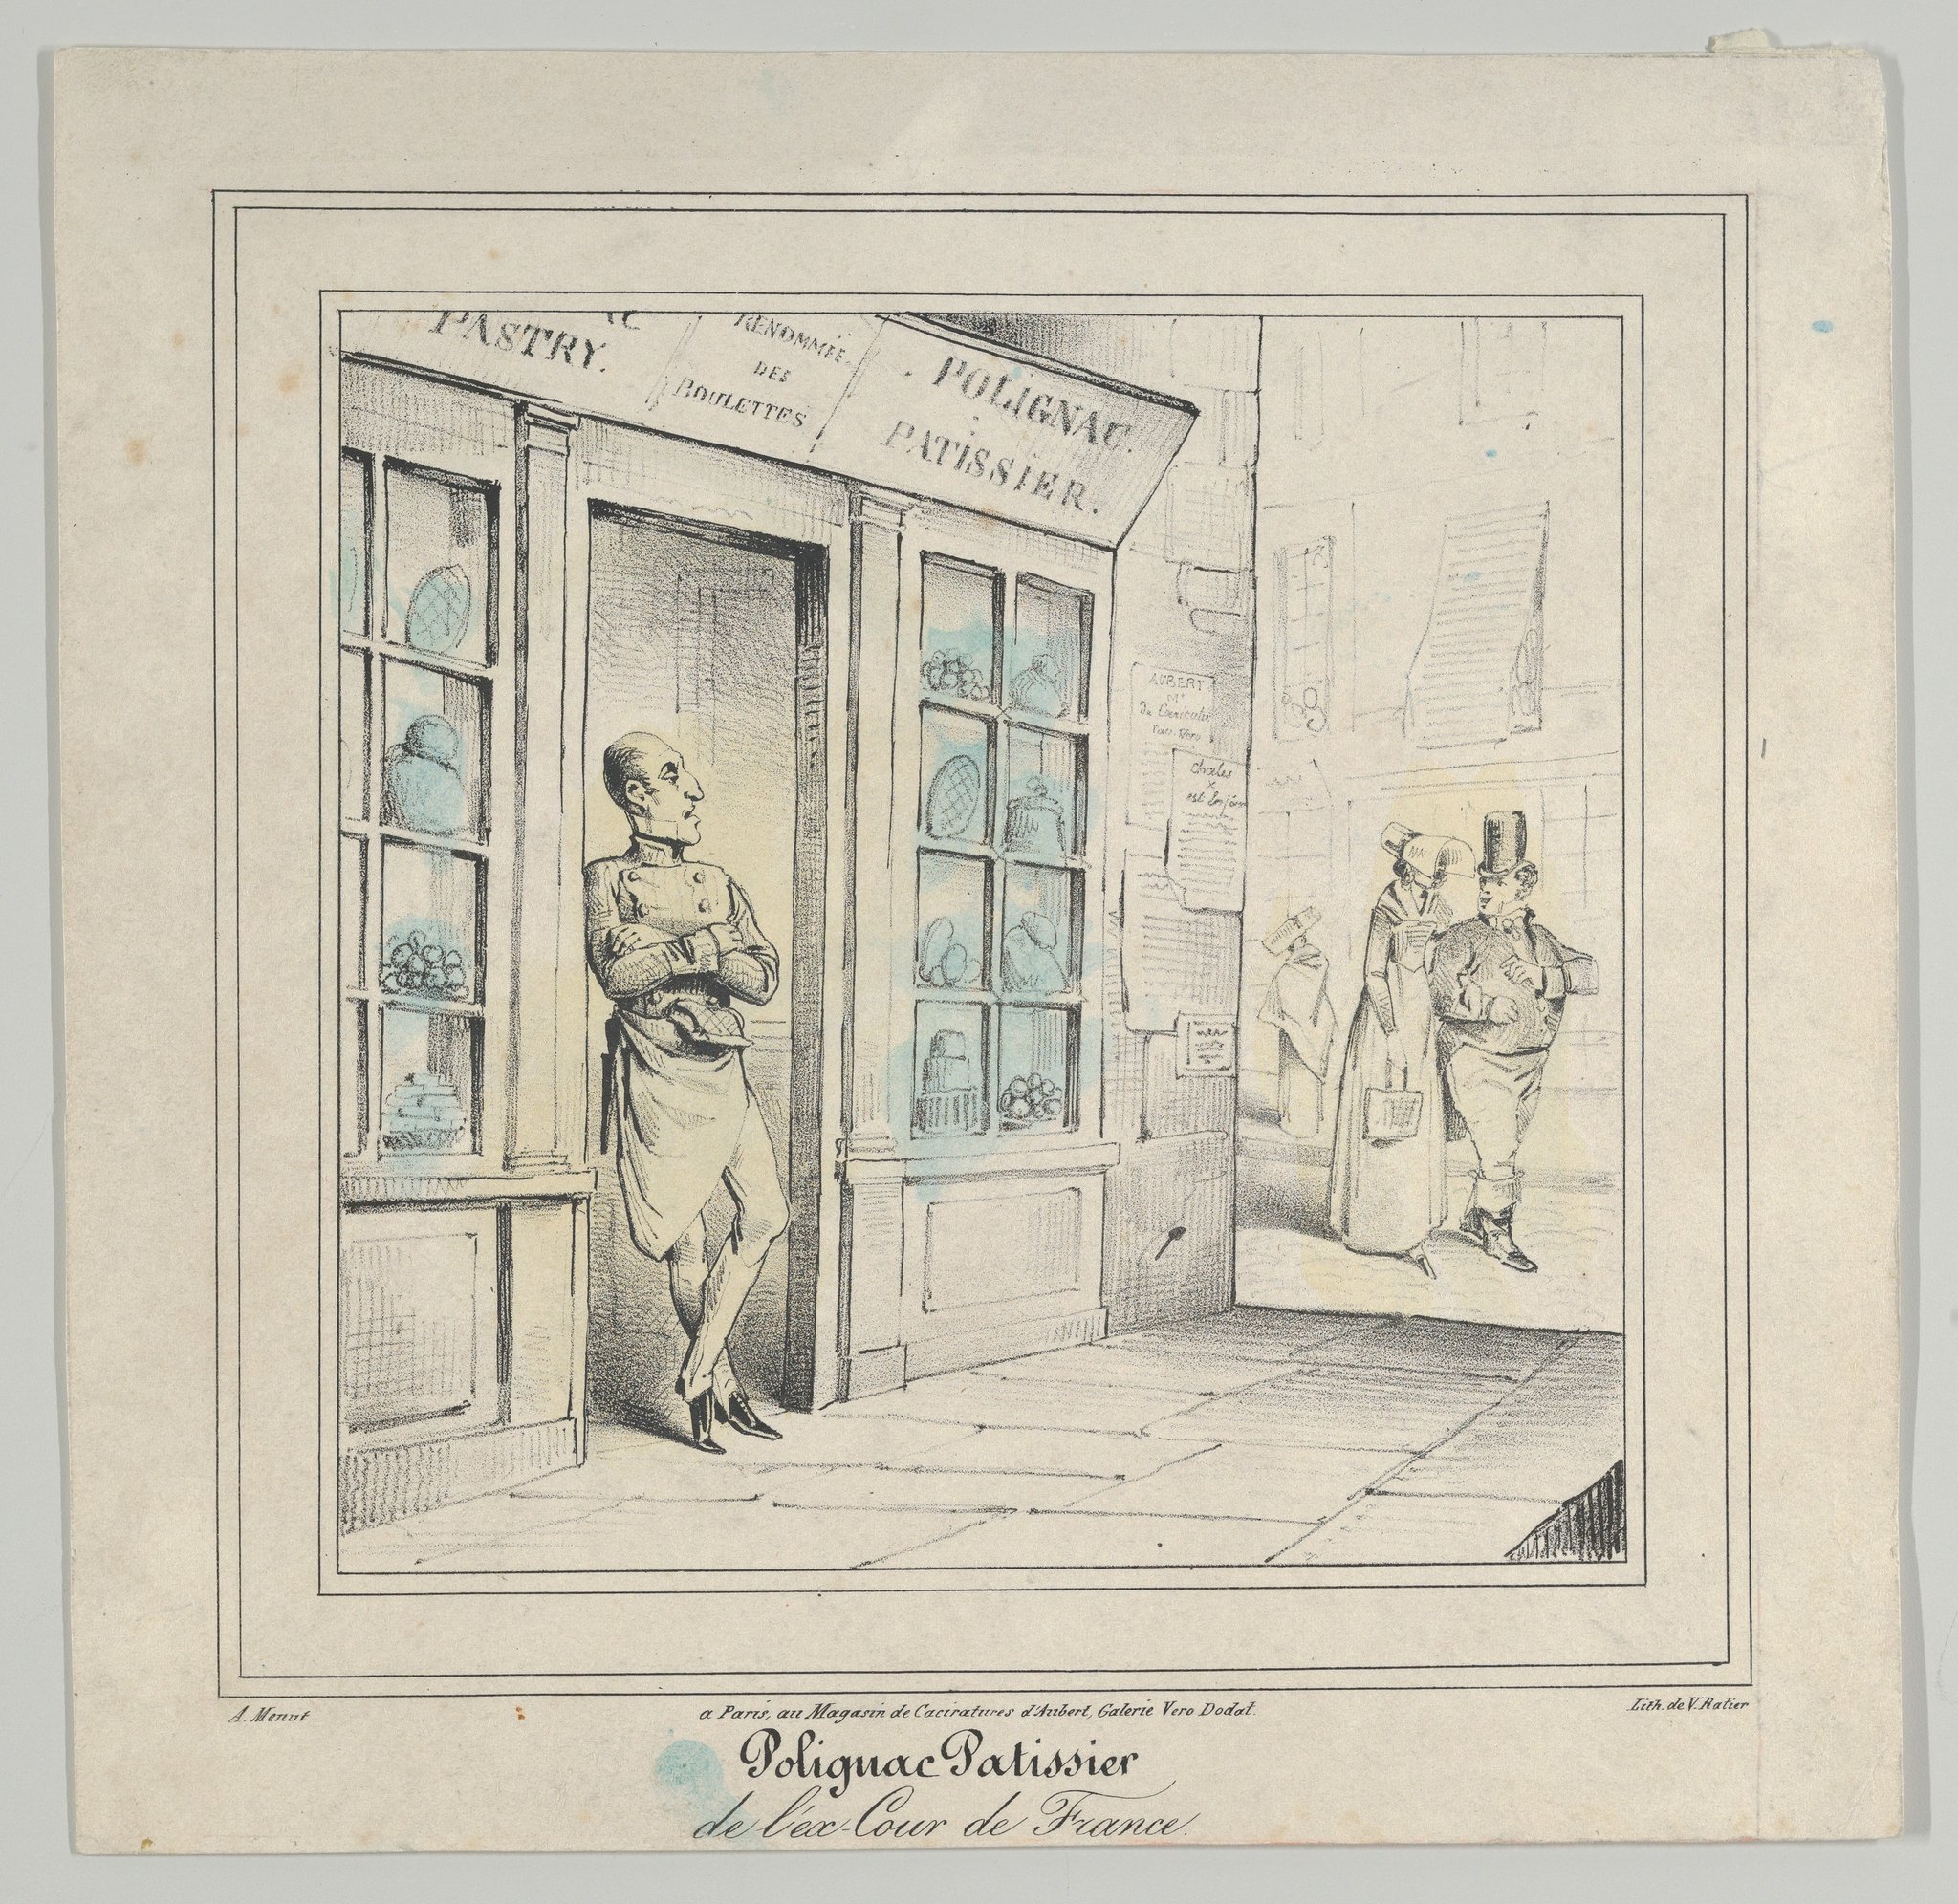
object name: print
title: Polignac Patissier de l'ex-Cour de France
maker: marie-alexandre alophe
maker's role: artist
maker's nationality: french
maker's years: 1811-1883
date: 1830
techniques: lithograph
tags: men,women